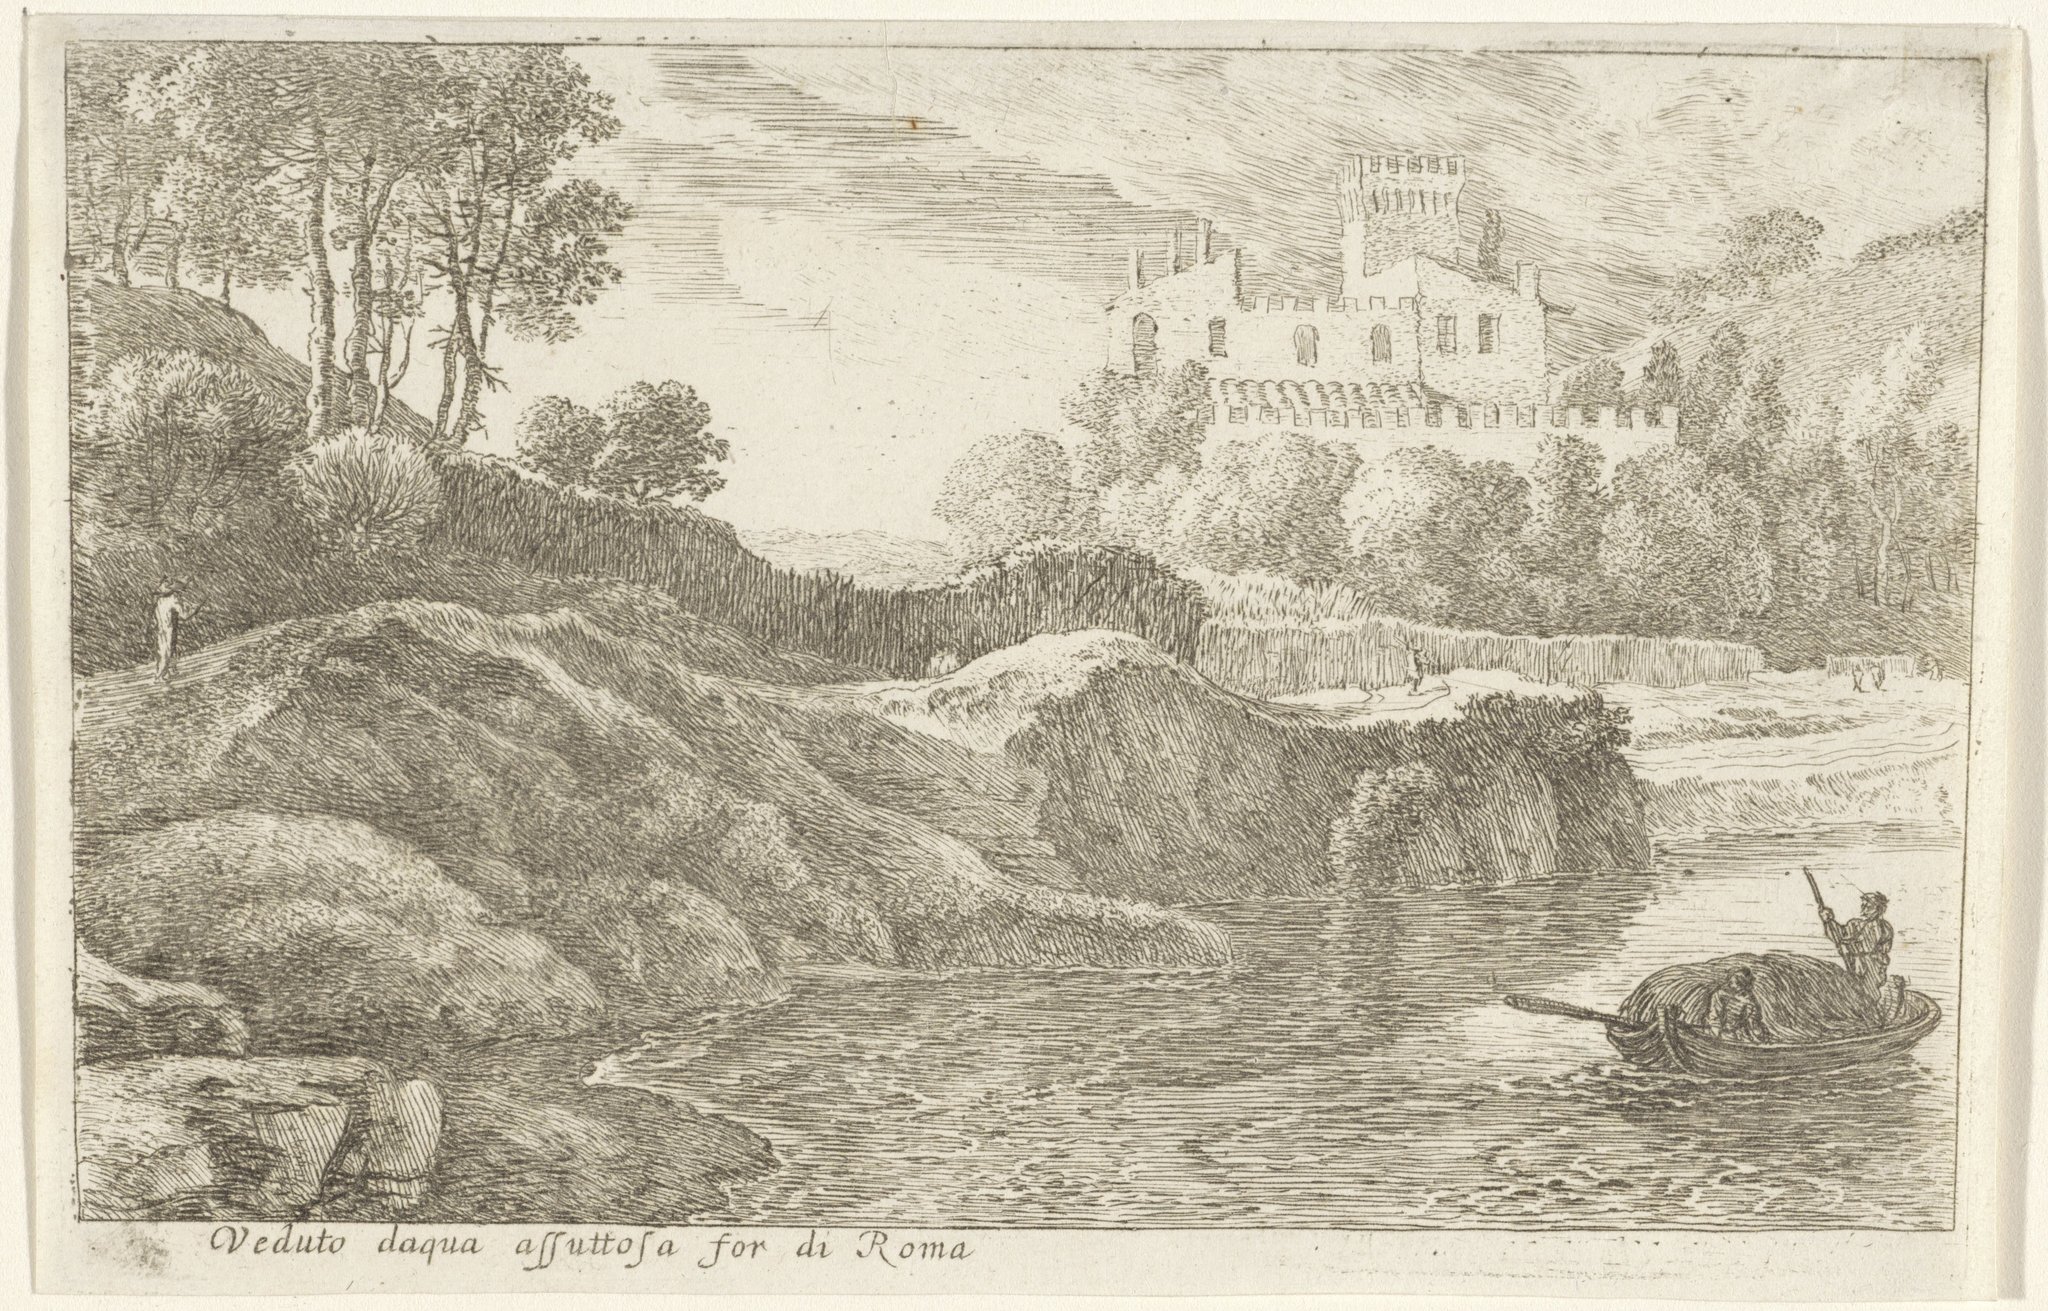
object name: print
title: Diverses veuës dedans et dehors de Rome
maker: herman van swanevelt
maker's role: draughtsman, painter, print maker, publisher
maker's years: 1603-1655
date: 1652-1653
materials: paper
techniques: etching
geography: paris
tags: landscapes, rural housing, e.g. country-house, villa, cottage, spring (fluids extracted from the earth), tower (of house or building), rome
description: Gezicht op de bron Acqua Acestosa te Rome met op de voorgrond een bemande vrachtboot en in de verte een versterkt gebouw met een toren op een heuvel.